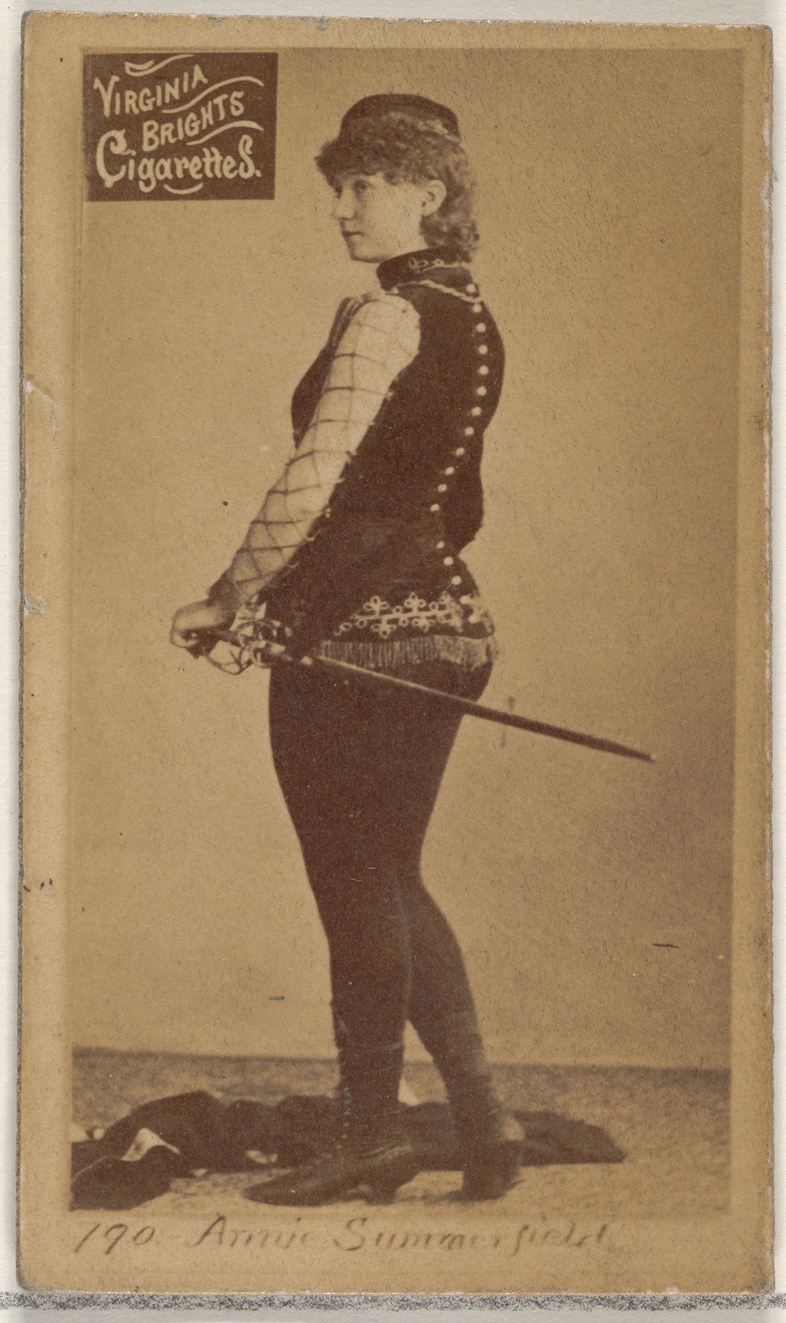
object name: photograph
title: Card 190, Annie Summerfield, from the Actors and Actresses series (N45, Type 2) for Virginia Brights Cigarettes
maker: allen & ginter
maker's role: publisher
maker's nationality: american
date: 1888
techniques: albumen silver print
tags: portraits,women,actresses